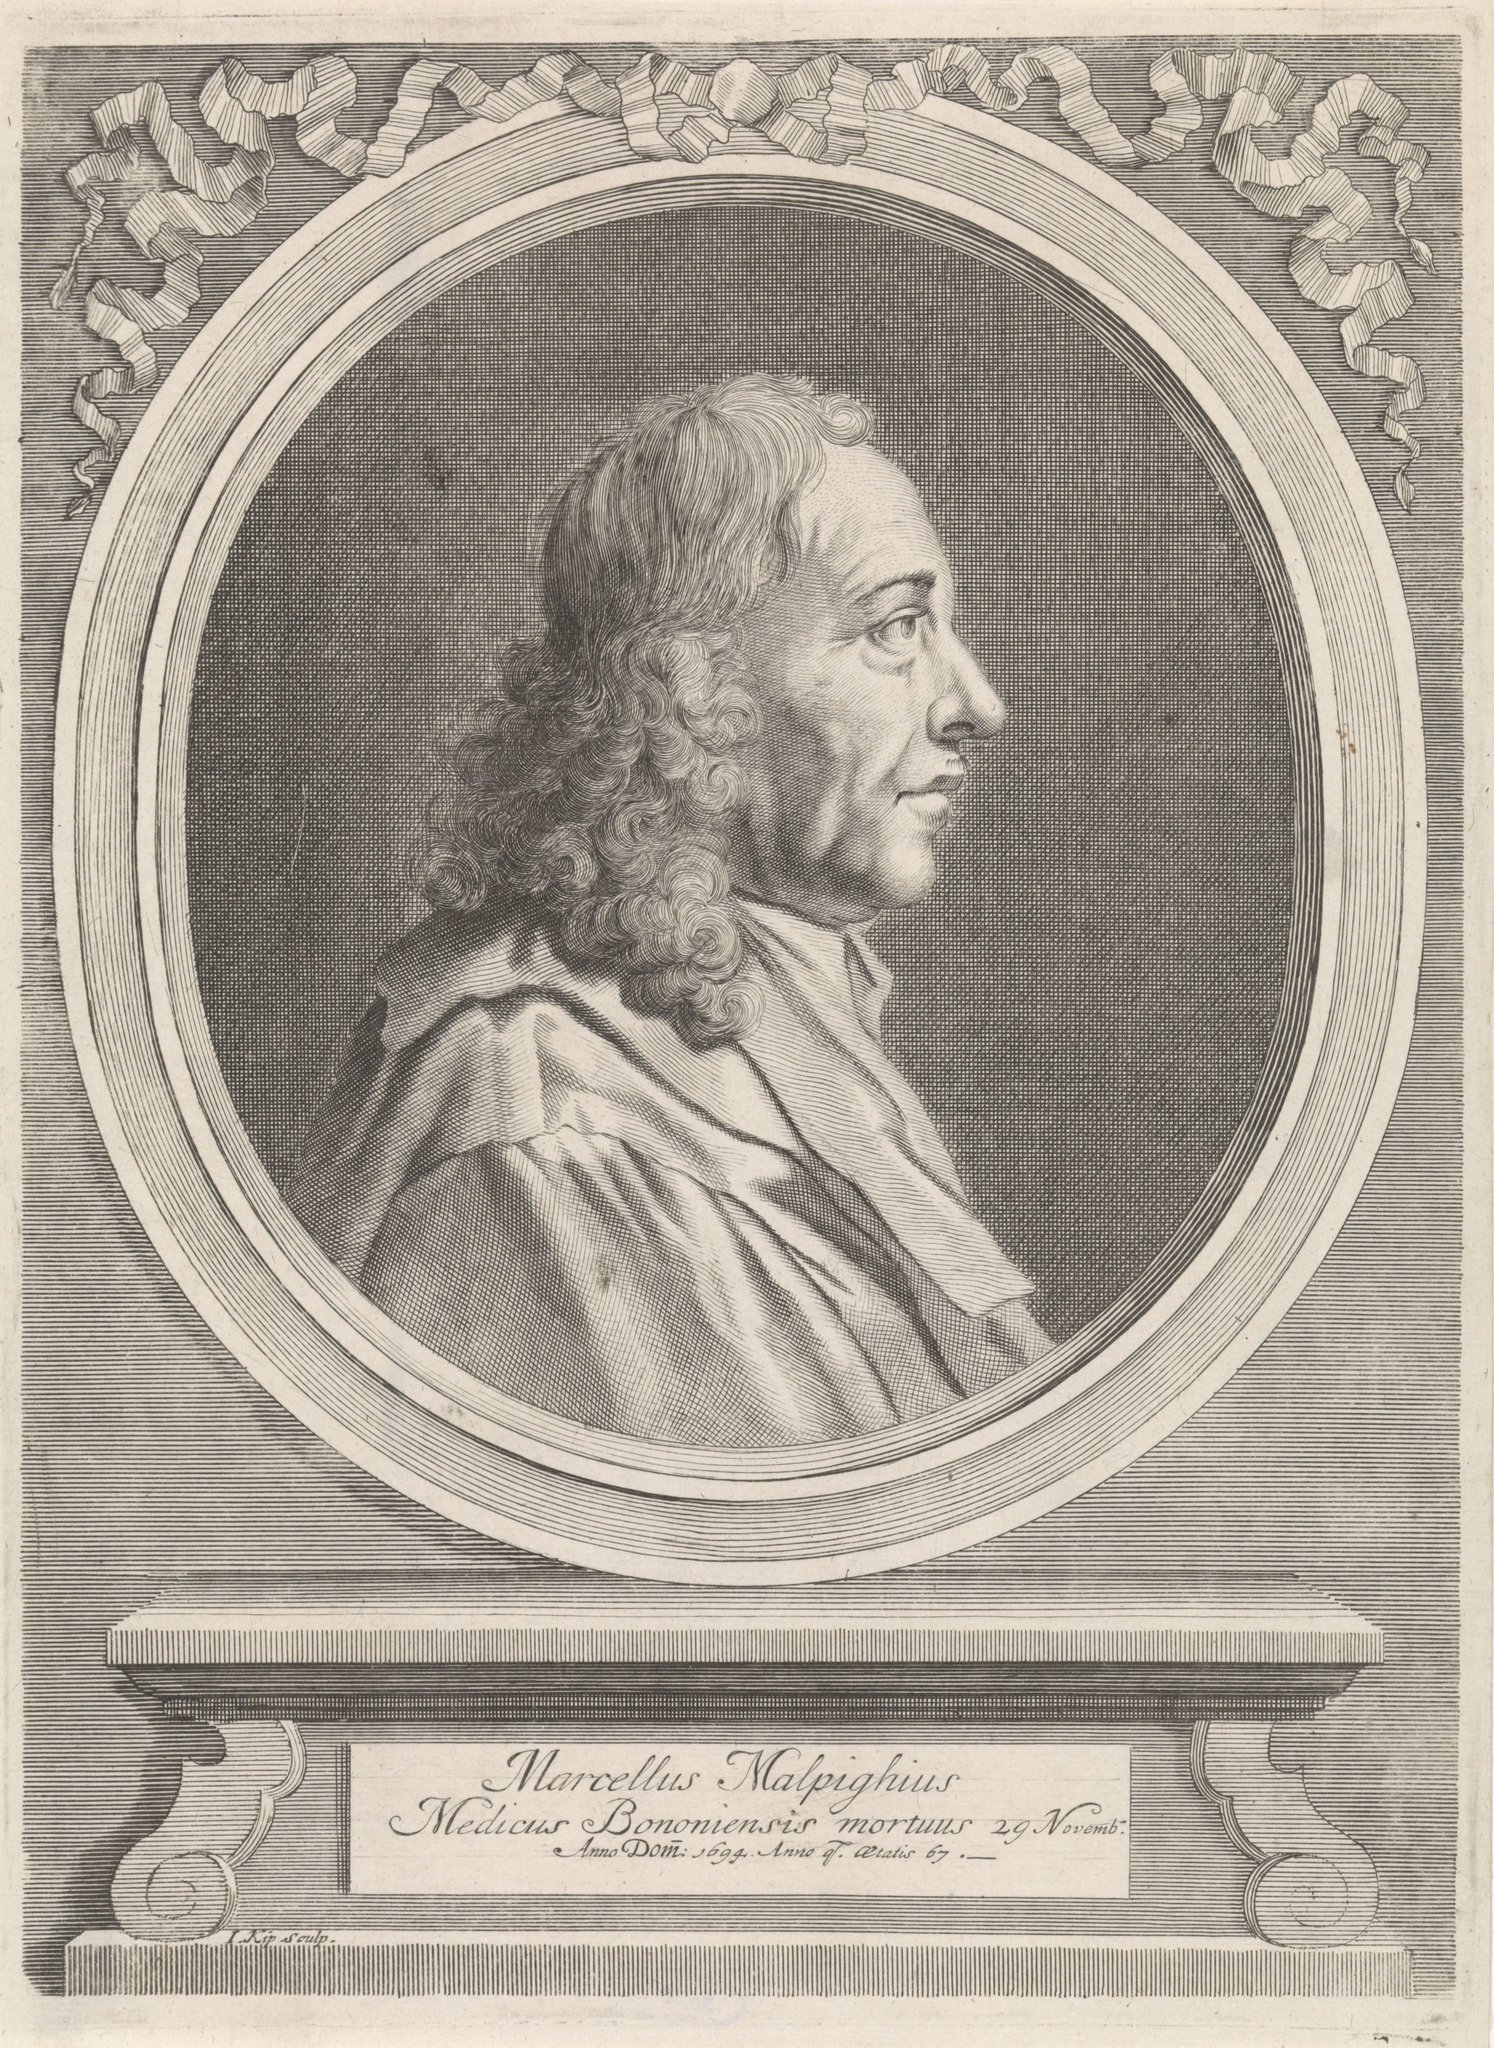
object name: print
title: Portret van Marcello Malpighi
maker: johannes kip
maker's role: print maker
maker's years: 1652-1722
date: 1694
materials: paper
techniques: engraving, etching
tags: rome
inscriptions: collector's mark: Lugt 2228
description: Portretbuste van Marcello Malpighi, arts en anatoom in Bologna en grondlegger van de microscopische anatomie, in ovaal.